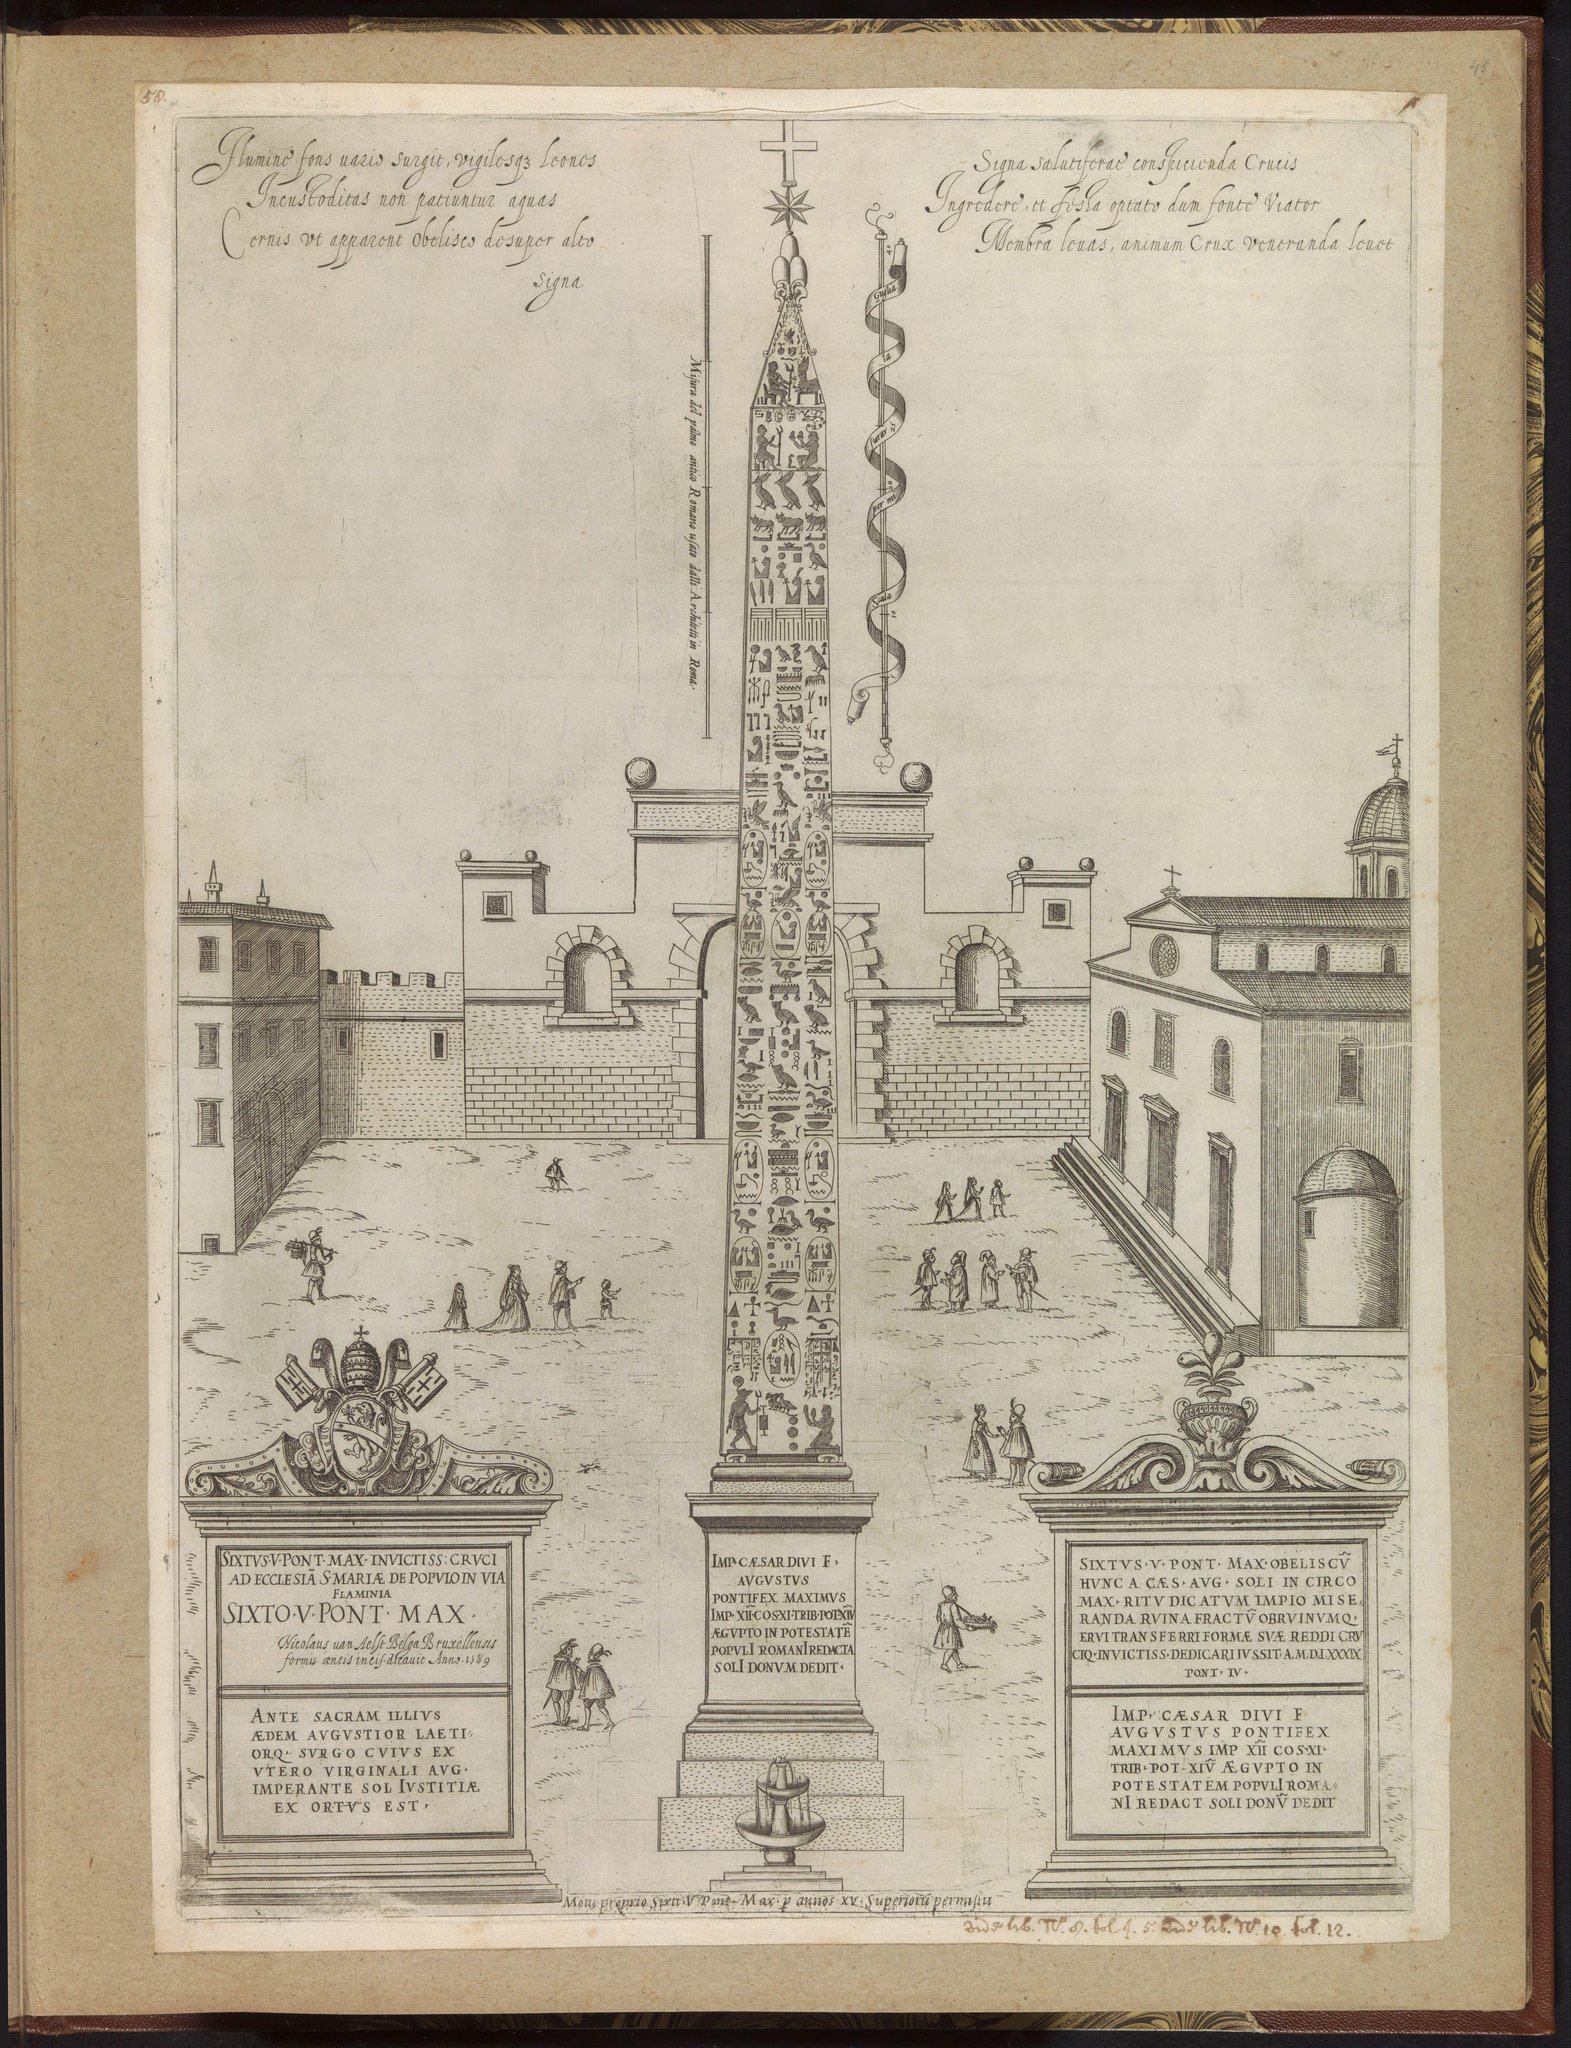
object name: album leaf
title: Speculum Romanae Magnificentiae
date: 1589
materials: paper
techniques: engraving, etching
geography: vatican city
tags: obelisk, needle, church (exterior), city-gate, rome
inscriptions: number: ‘58’, inscription: ‘Ende lib. No. 8. fol. 4. 5. Ende lib. No. 10. fol. 12.’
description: Deze prent behoort tot het prentcorpus dat bekend staat als de ‘Speculum Romanae Magnificentiae’ (‘Spiegel van Romeinse pracht’). Dit corpus, bestaande uit prenten met voorstellingen van kunstwerken en gebouwen uit het antieke en het moderne Rome, vond zijn oorsprong bij uitgevers Antonio Salamanca en Antonio Lafreri. Deze twee buitenlandse uitgevers bundelden hun krachten te Rome in de periode 1553-1563. Hun prenten werden al snel razend populair bij toeristen en verzamelaars, die de prenten individueel of in grote groepen aanschaften. Grote groepen Speculum-prenten werden vaak op aanvraag samengebonden in albums. Er zijn verschillende Speculum-albums overgeleverd die allemaal verschillen van inhoud. Tussen 1573 en 1577 gaf Antonio Lafreri een speciale titelpagina uit (met de titel ‘Speculum Romanae Magnificentiae’) die mensen voor hun verzamelingen konden voegen. Het overlijden van Lafreri in 1577 betekende niet het einde van het corpus. Een groot deel van de koperplaten ging over op Claudio en Stefano Duchetti. De rest raakte verspreid over verschillende andere uitgevers. De populariteit van de Speculum-prenten wist nog geruime periode uitgevers te inspireren tot het laten maken van kopieën en het toevoegen van nieuwe prenten aan het corpus.